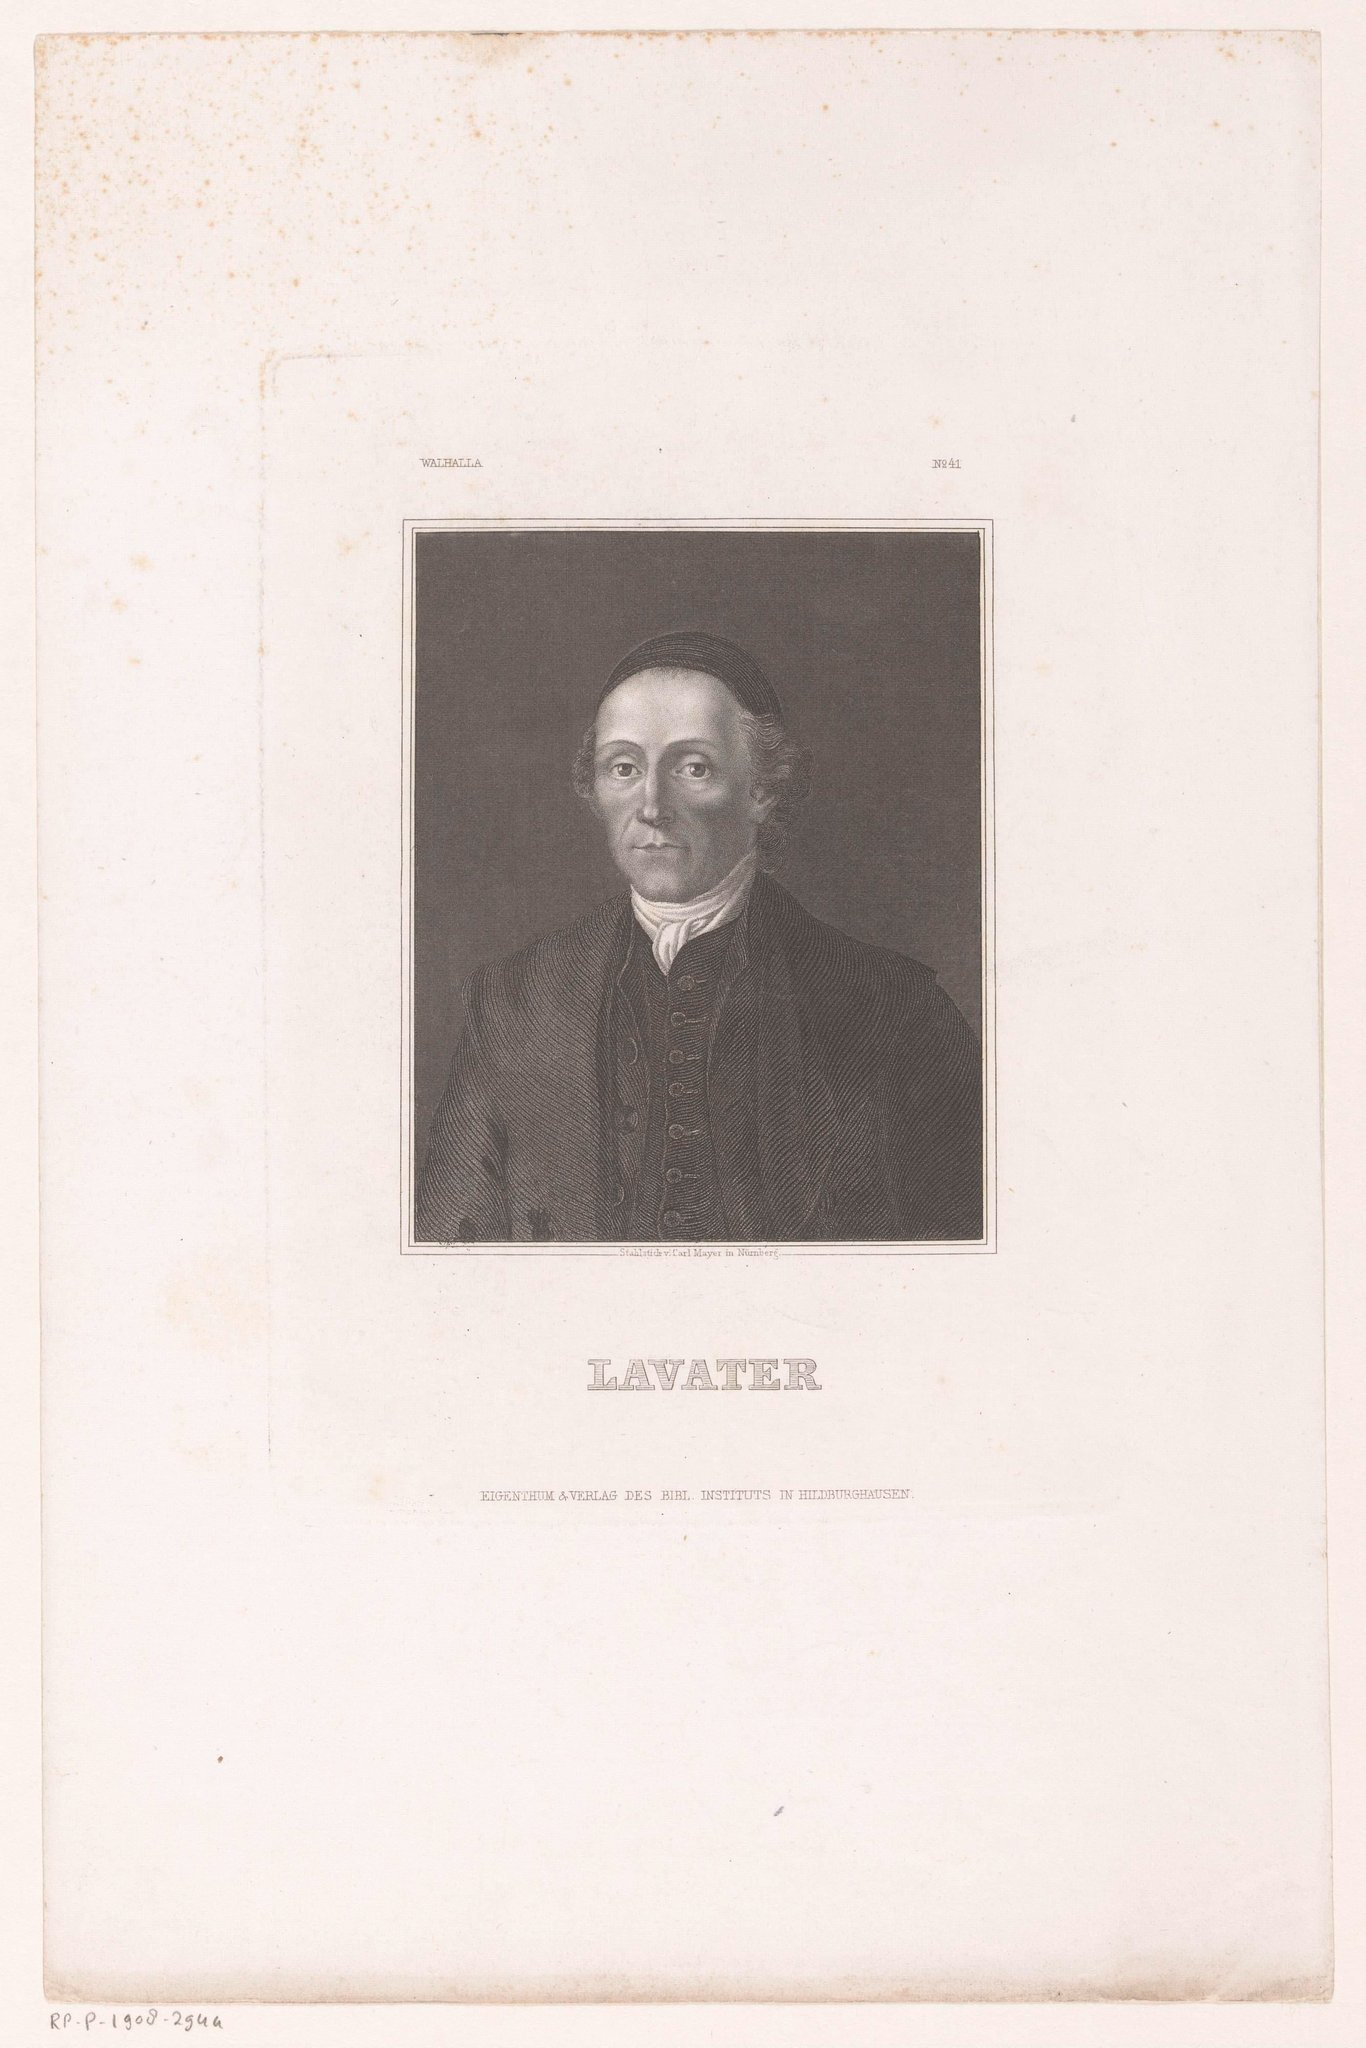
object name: print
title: Portret van Johann Kaspar Lavater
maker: carl mayer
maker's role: print maker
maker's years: 1798-1868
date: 1829-1840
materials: paper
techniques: engraving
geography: hildburghausen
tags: johann caspar lavater, historical persons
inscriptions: collector's mark: Lugt 2228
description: Prent afkomstig uit de portretserie 'Walhalla, eine Gallerie der Bildnisse der Zierden des Menschengeschlechts', uitgegeven door het Bibliographisches Institut tussen 1852-1856.